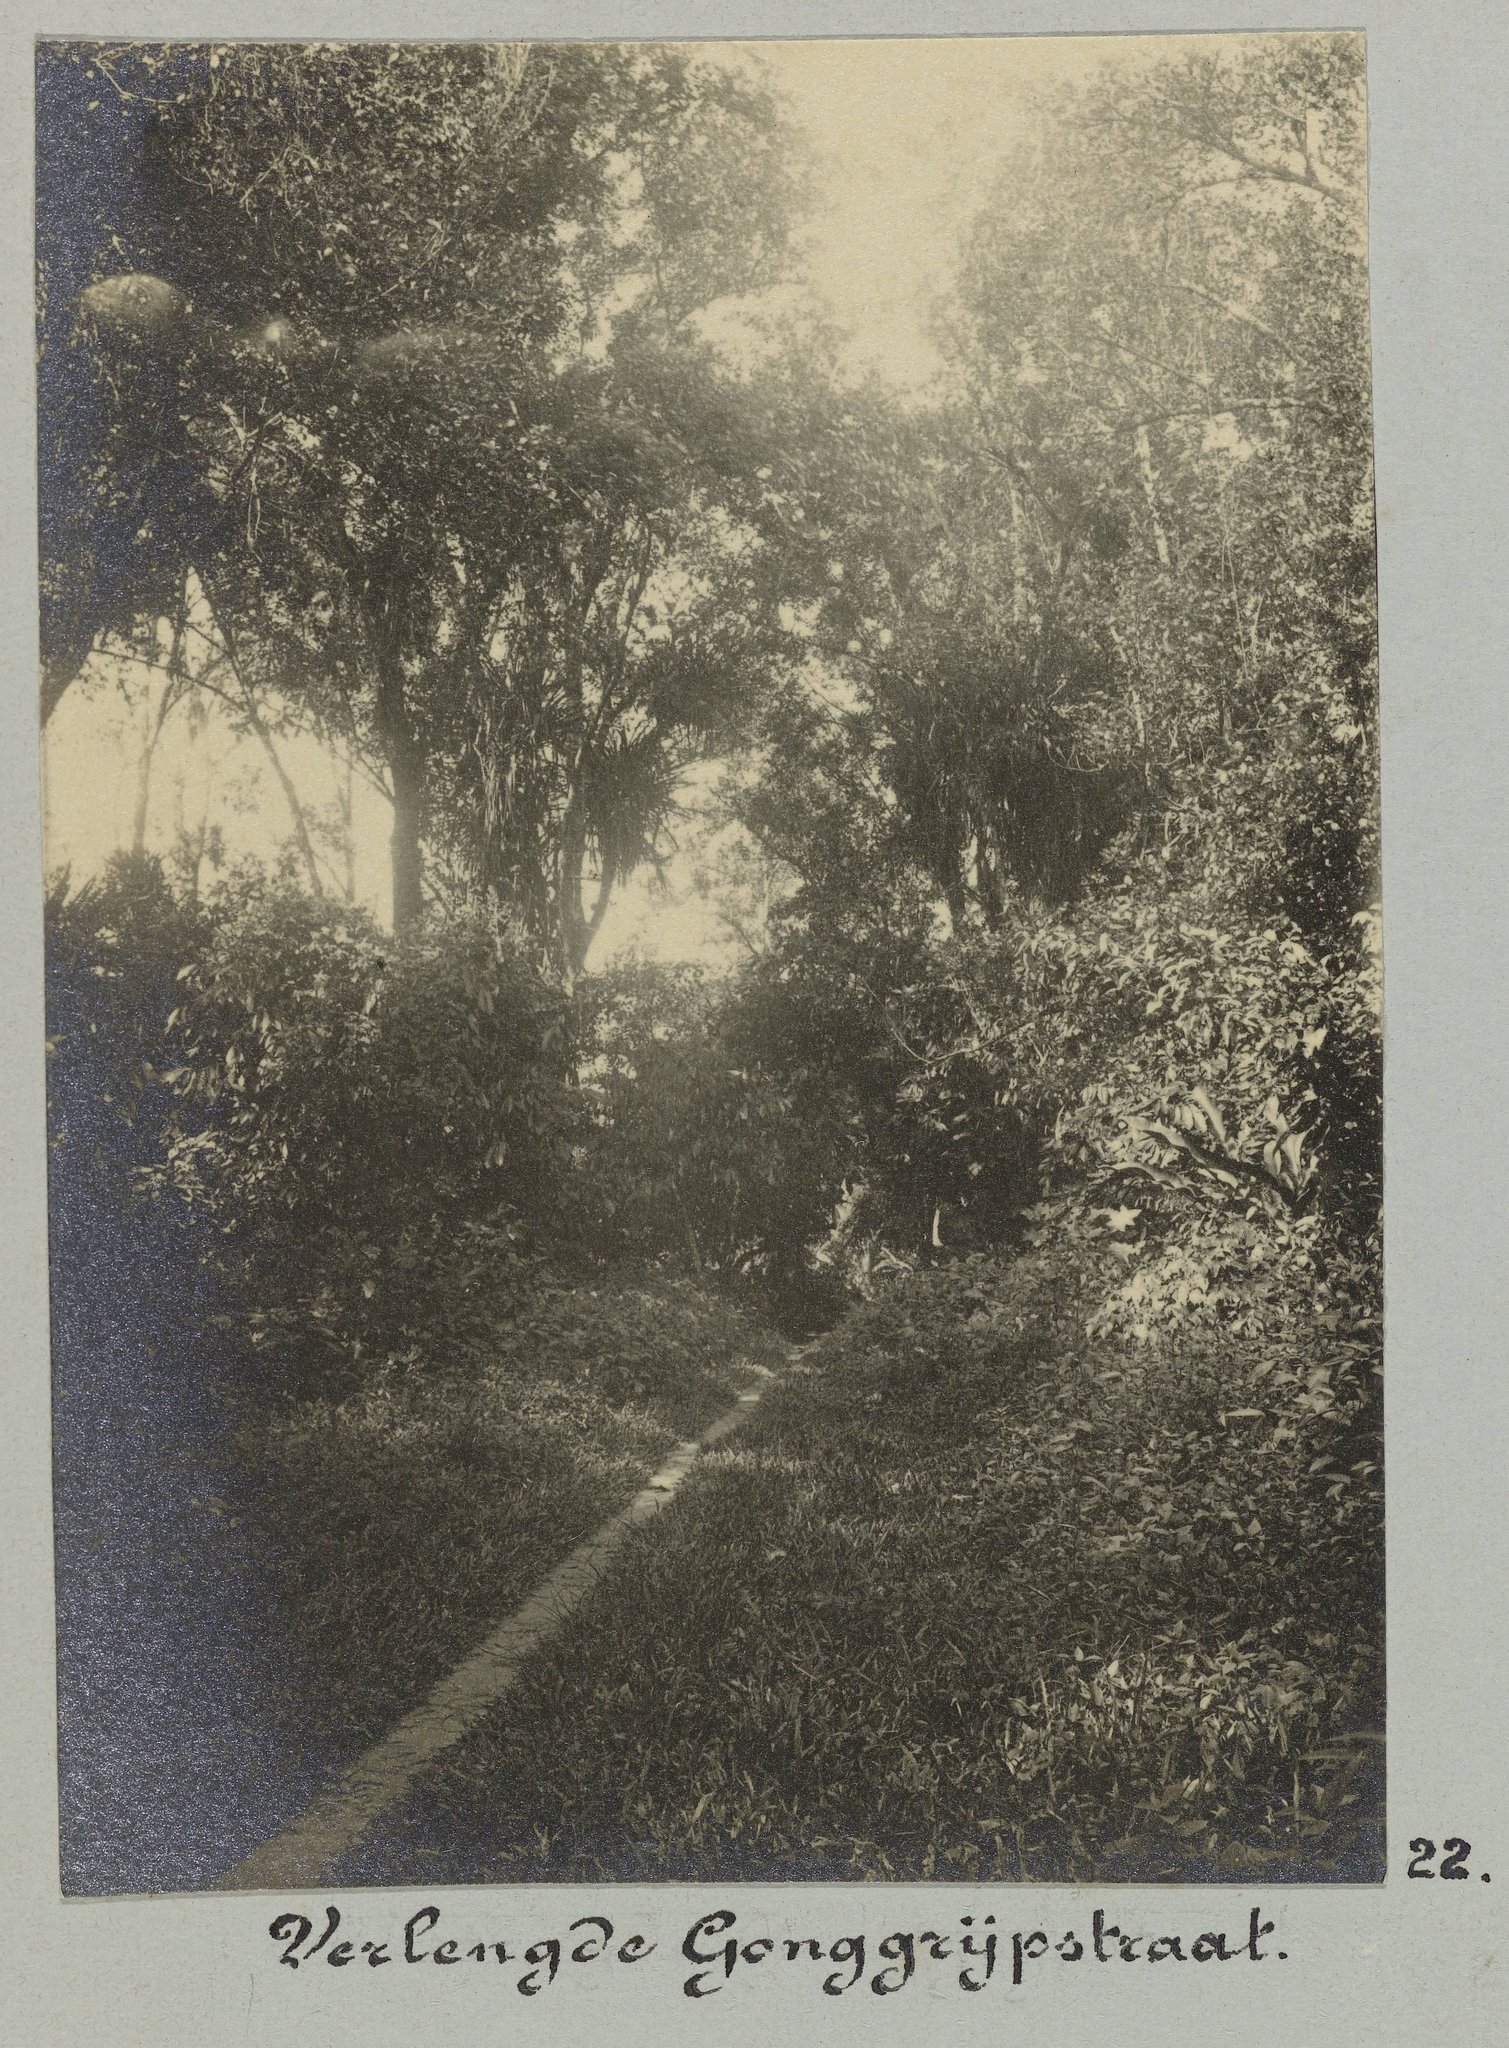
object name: photograph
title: Verlengde Gonggrijpstraat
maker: hendrik doijer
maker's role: engineer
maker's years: 1863-1925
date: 1903-1910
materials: photographic support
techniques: gelatin silver print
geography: suriname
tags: suriname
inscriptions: inscription: ‘22. / Verlengde Gonggrijpstraat.’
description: Smalle weg lopend tussen gras en bomen, in het onderschrift aangeduid als de verlengde Gonggrijpstraat. Onderdeel van het fotoalbum Souvenir de Voyage (deel 1), over het leven van de familie Doijer in en rond de plantage Ma Retraite in Suriname in de jaren 1903-1910.